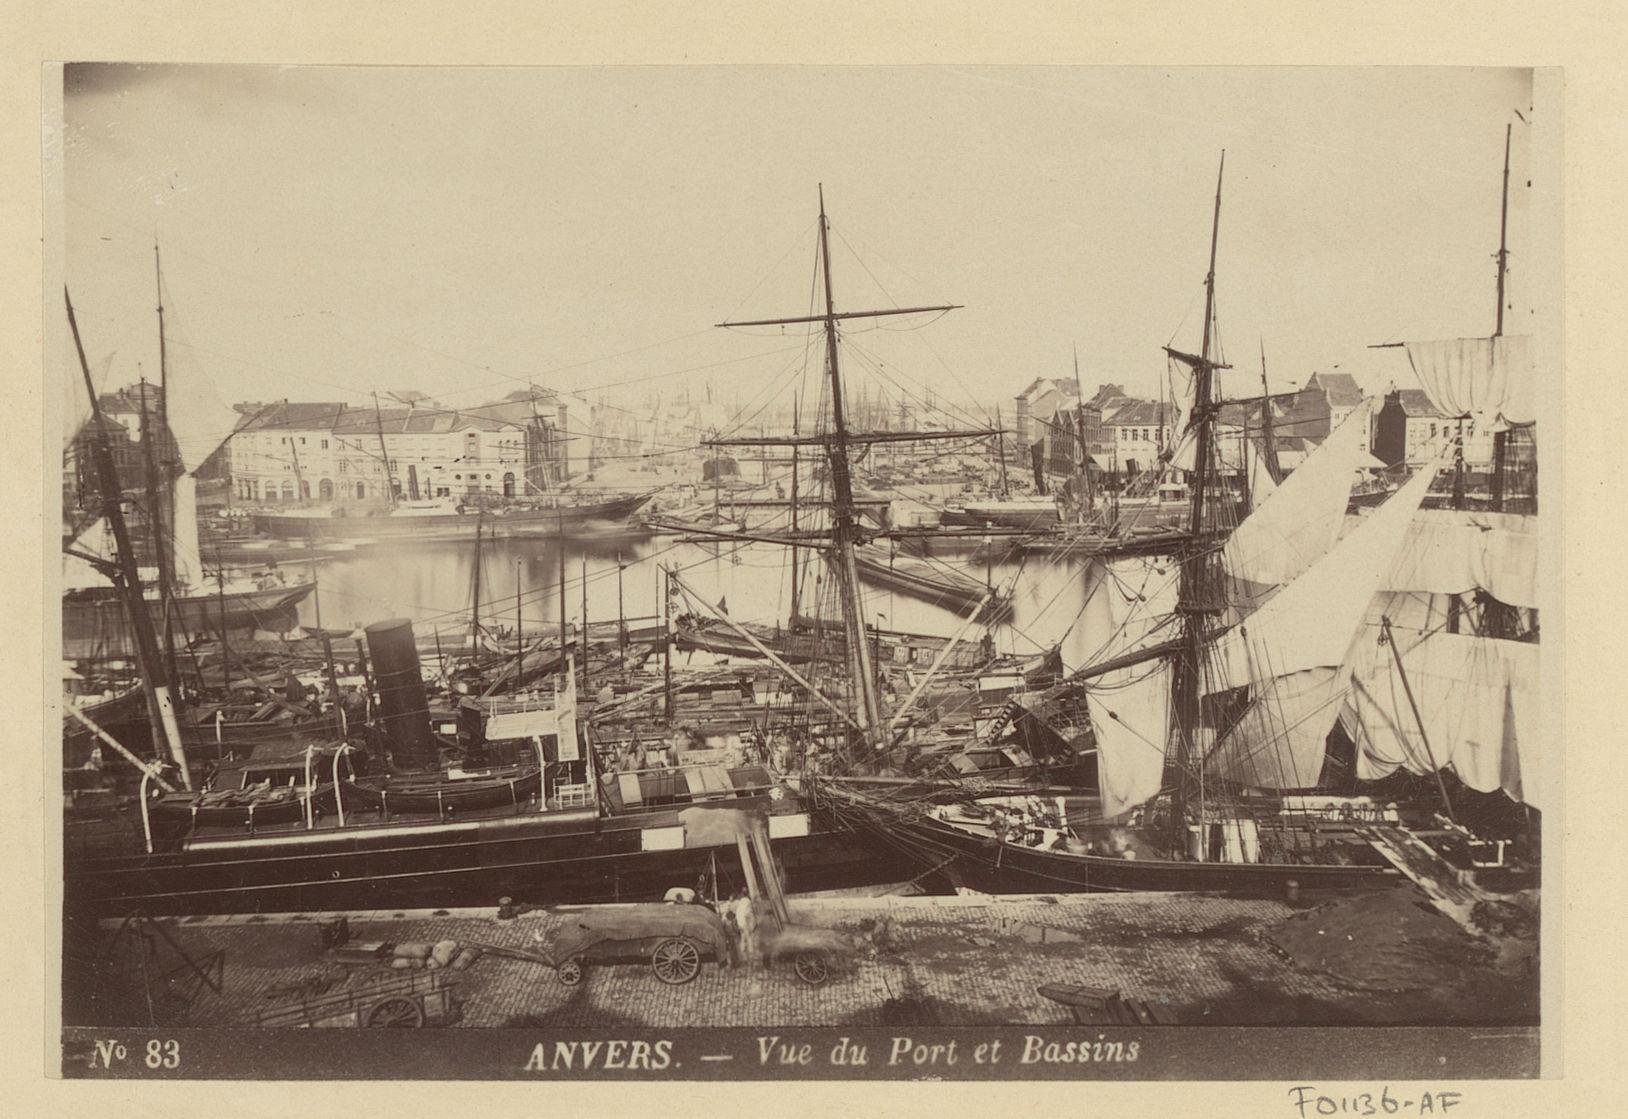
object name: photograph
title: ANVERS. - Vue du Port et Bassins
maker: gustave hermans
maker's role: publisher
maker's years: 1856-1934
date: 1870-1892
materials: photographic support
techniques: albumen print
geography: antwerp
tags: harbour (+ view ~ vehicle, ship, etc.), antwerp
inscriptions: number: ‘83’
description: Onderdeel van Fotoalbum met opnames van bezienswaardigheden in België, Duitsland en Noorwegen.